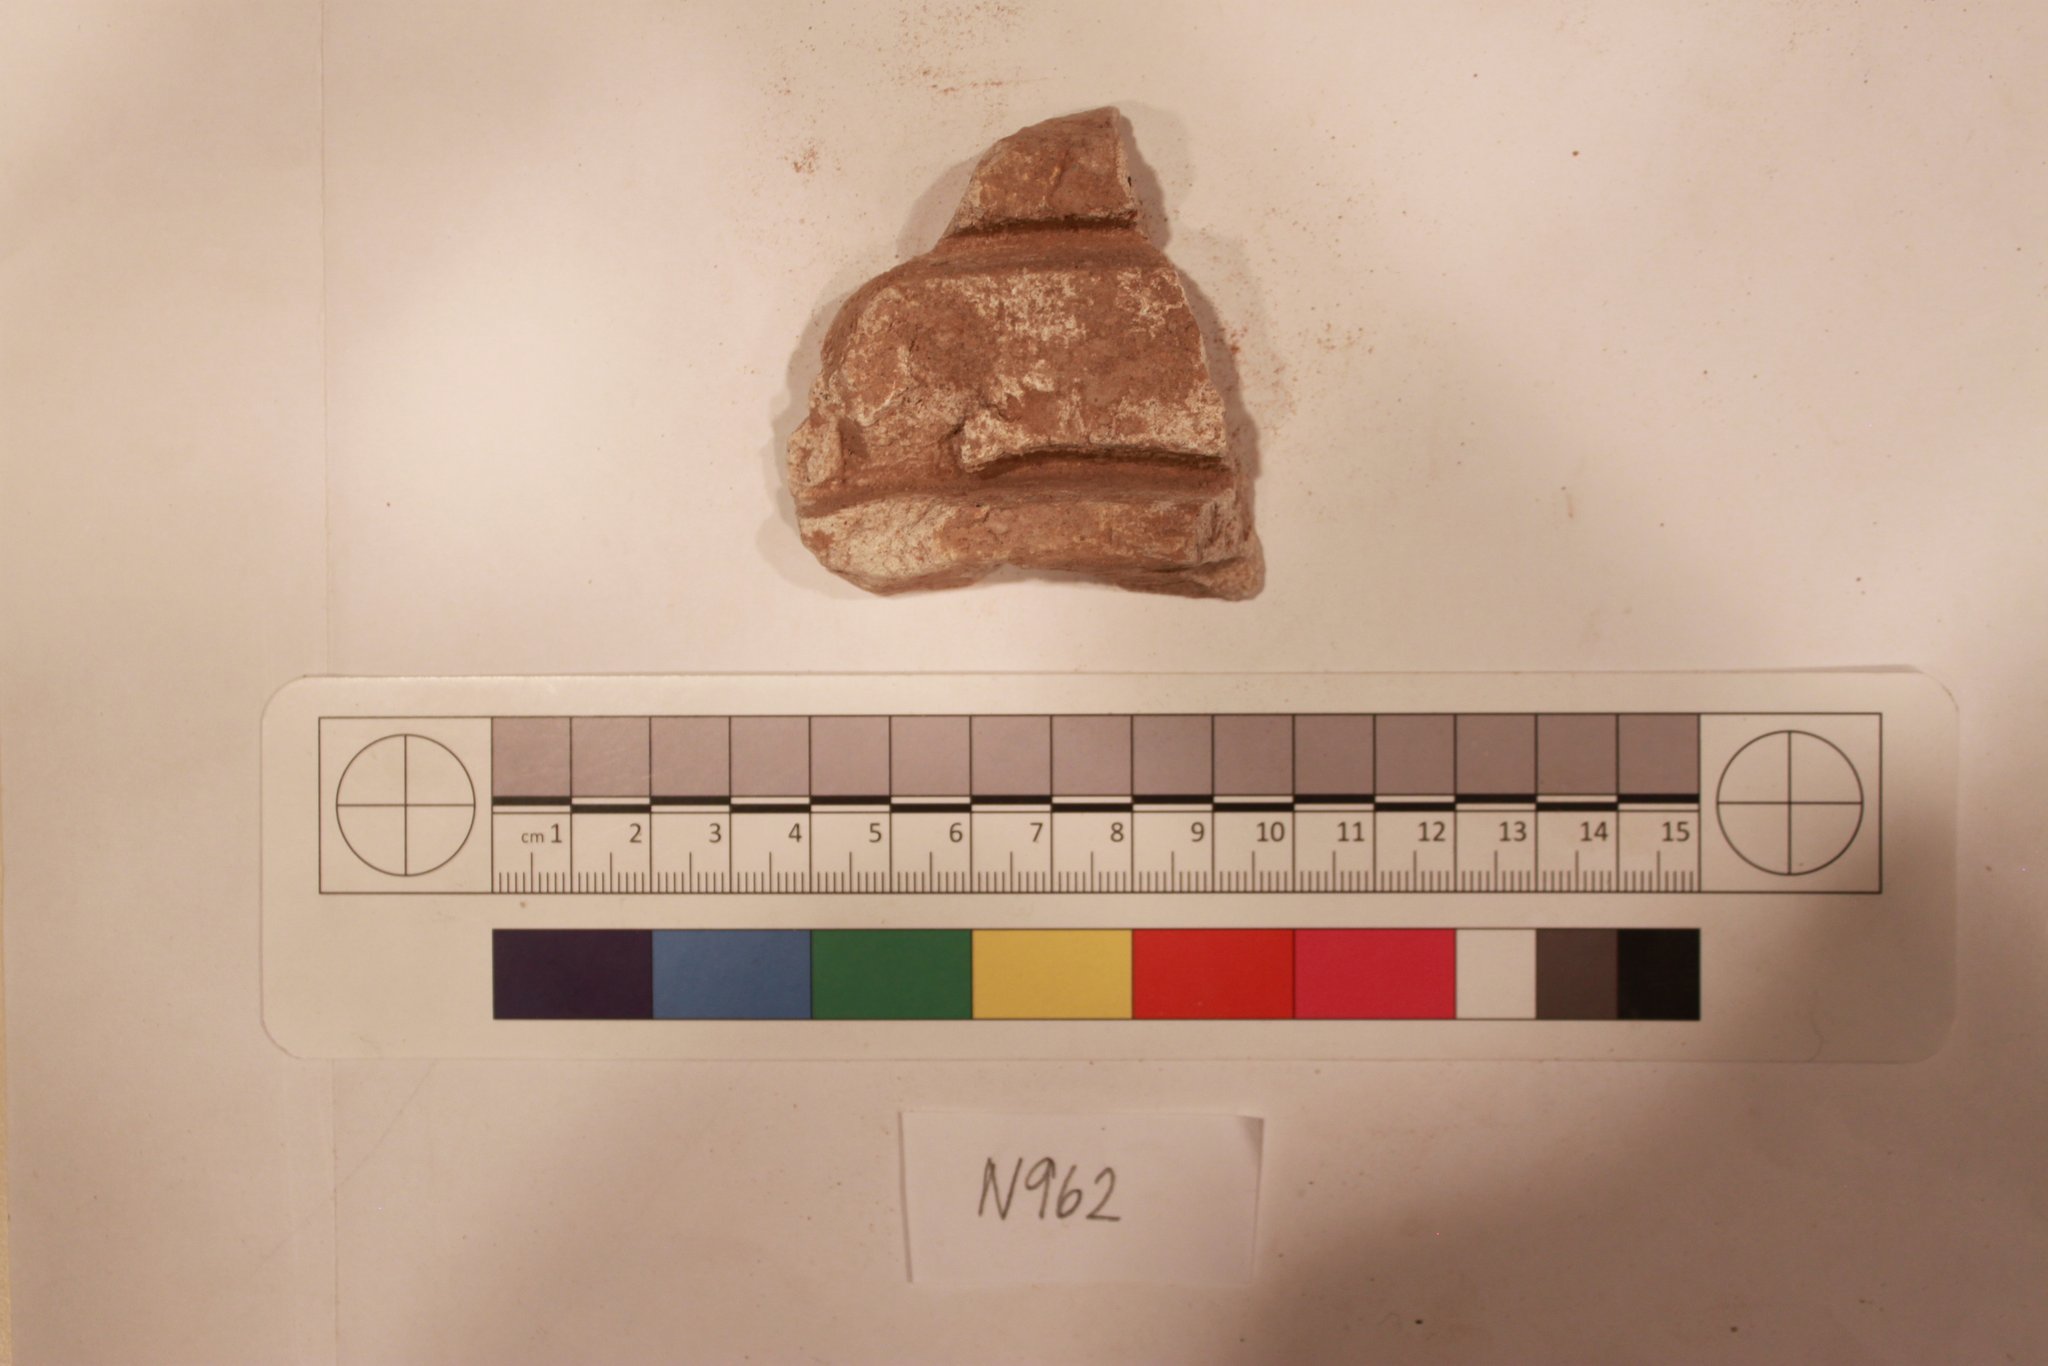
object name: fragment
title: Stucco Fragment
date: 701-1200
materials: plaster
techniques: carving, painting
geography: iran